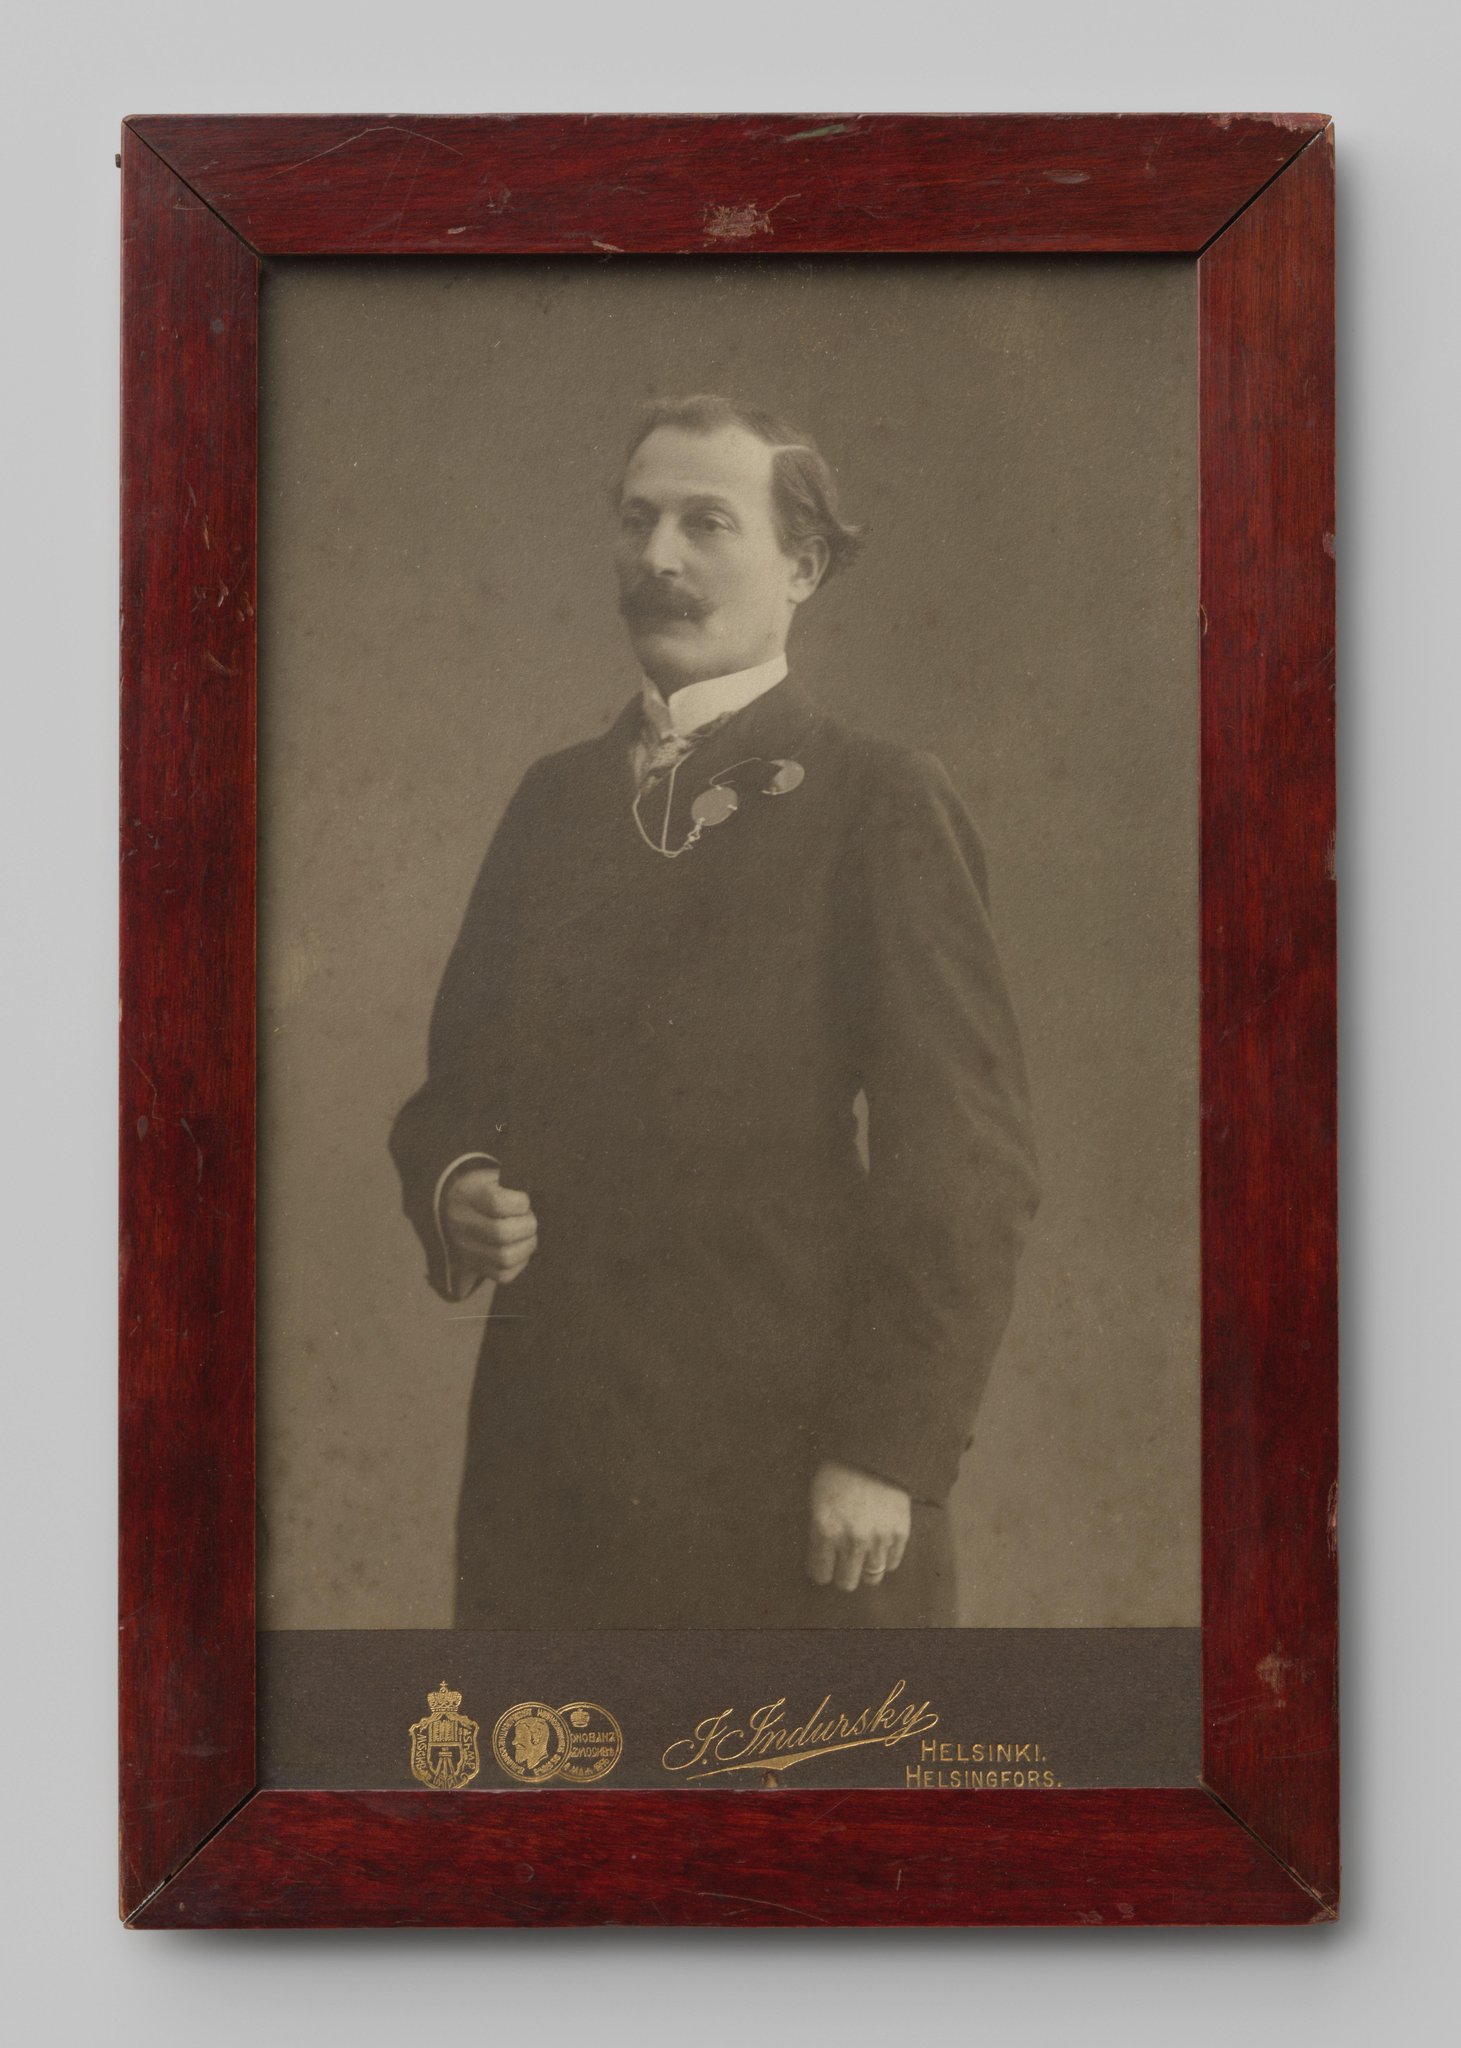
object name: frame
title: Portret van een onbekende man met bril op revers gespeld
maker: j. indursky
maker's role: fotograaf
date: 1896-1920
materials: paper, cardboard, glass, metal, wood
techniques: gelatin silver print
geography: helsinki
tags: eyeglasses, spectacles, moustache, adult man, anonymous historical person portrayed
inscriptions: inscription: ‘[...] 1896/ I. Indursky/ HELSINKI/ HELSINGFORS.’